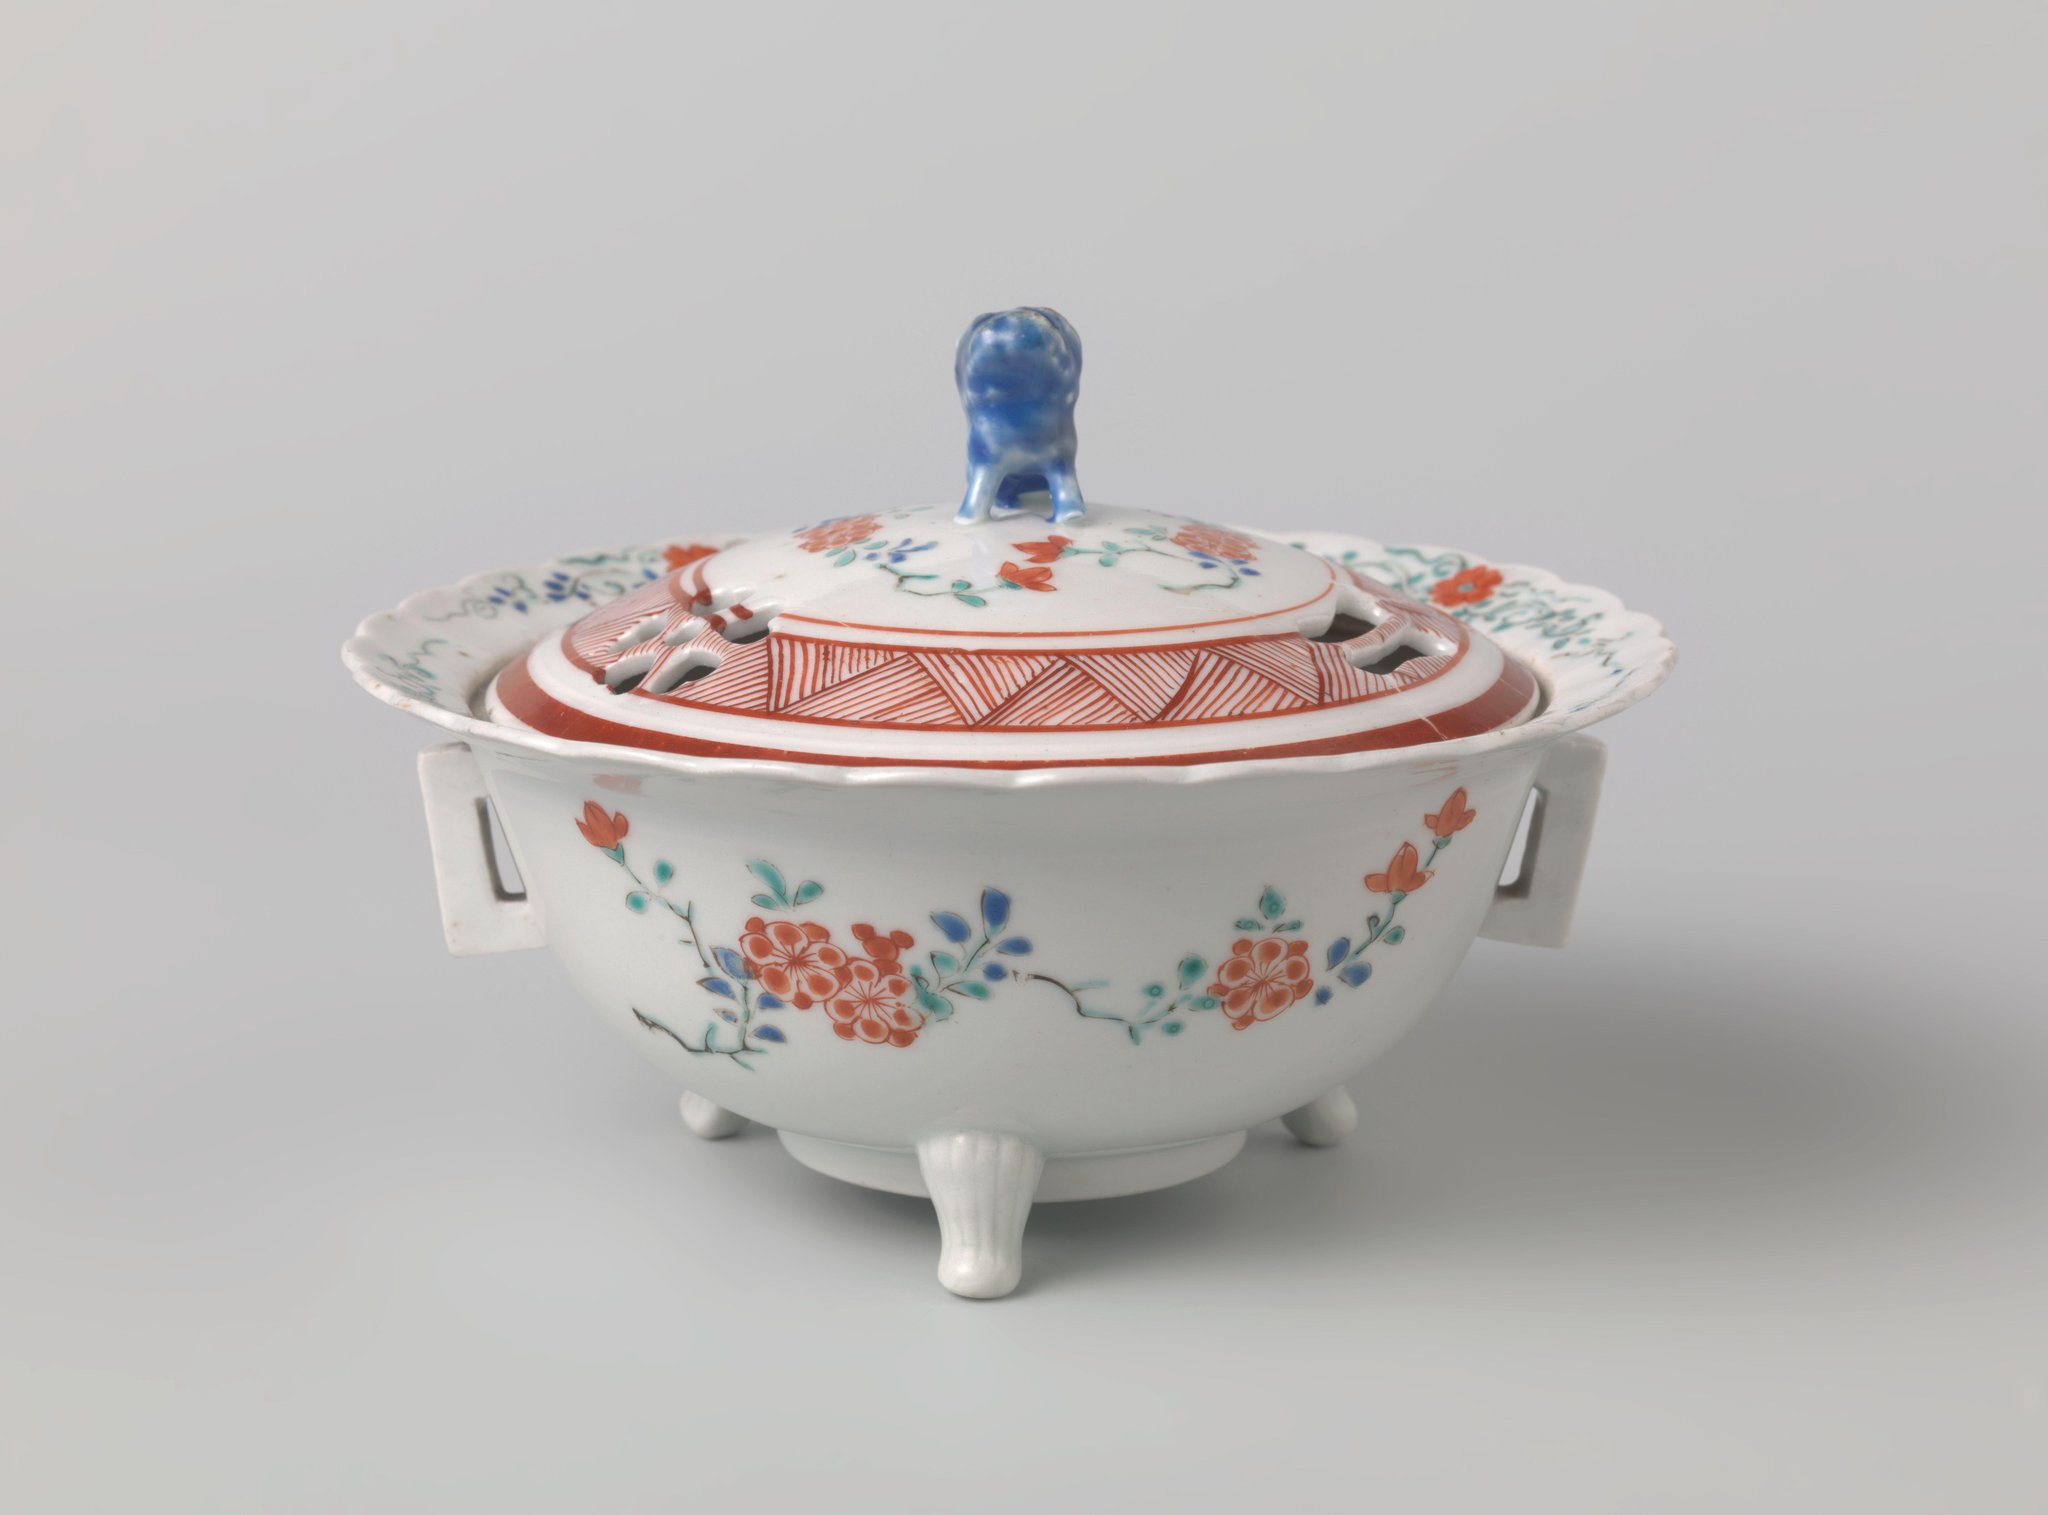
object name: incense burner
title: Incense burner with lid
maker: Anonymous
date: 1670-1690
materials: glaze, paint, porcelain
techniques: firing, turning, vitrification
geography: japan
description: Wierookbrander van porselein in de vorm van een ronde kom met voetring en een platte, geribde rand, op drie pootjes, met twee rechthoekige oren, met een bolle deksel bekroond met een shishi (leeuwhond) met openingen in de vorm van een waaier, een kersenbloesem en een enkel kersenbloesemblad. Beschilderd op het glazuur in blauw, rood groen en zwart met prunustakken en een rand van driehoeken met lijnen op de deksel. Deksel is gerestaureerd. Kakiemon.